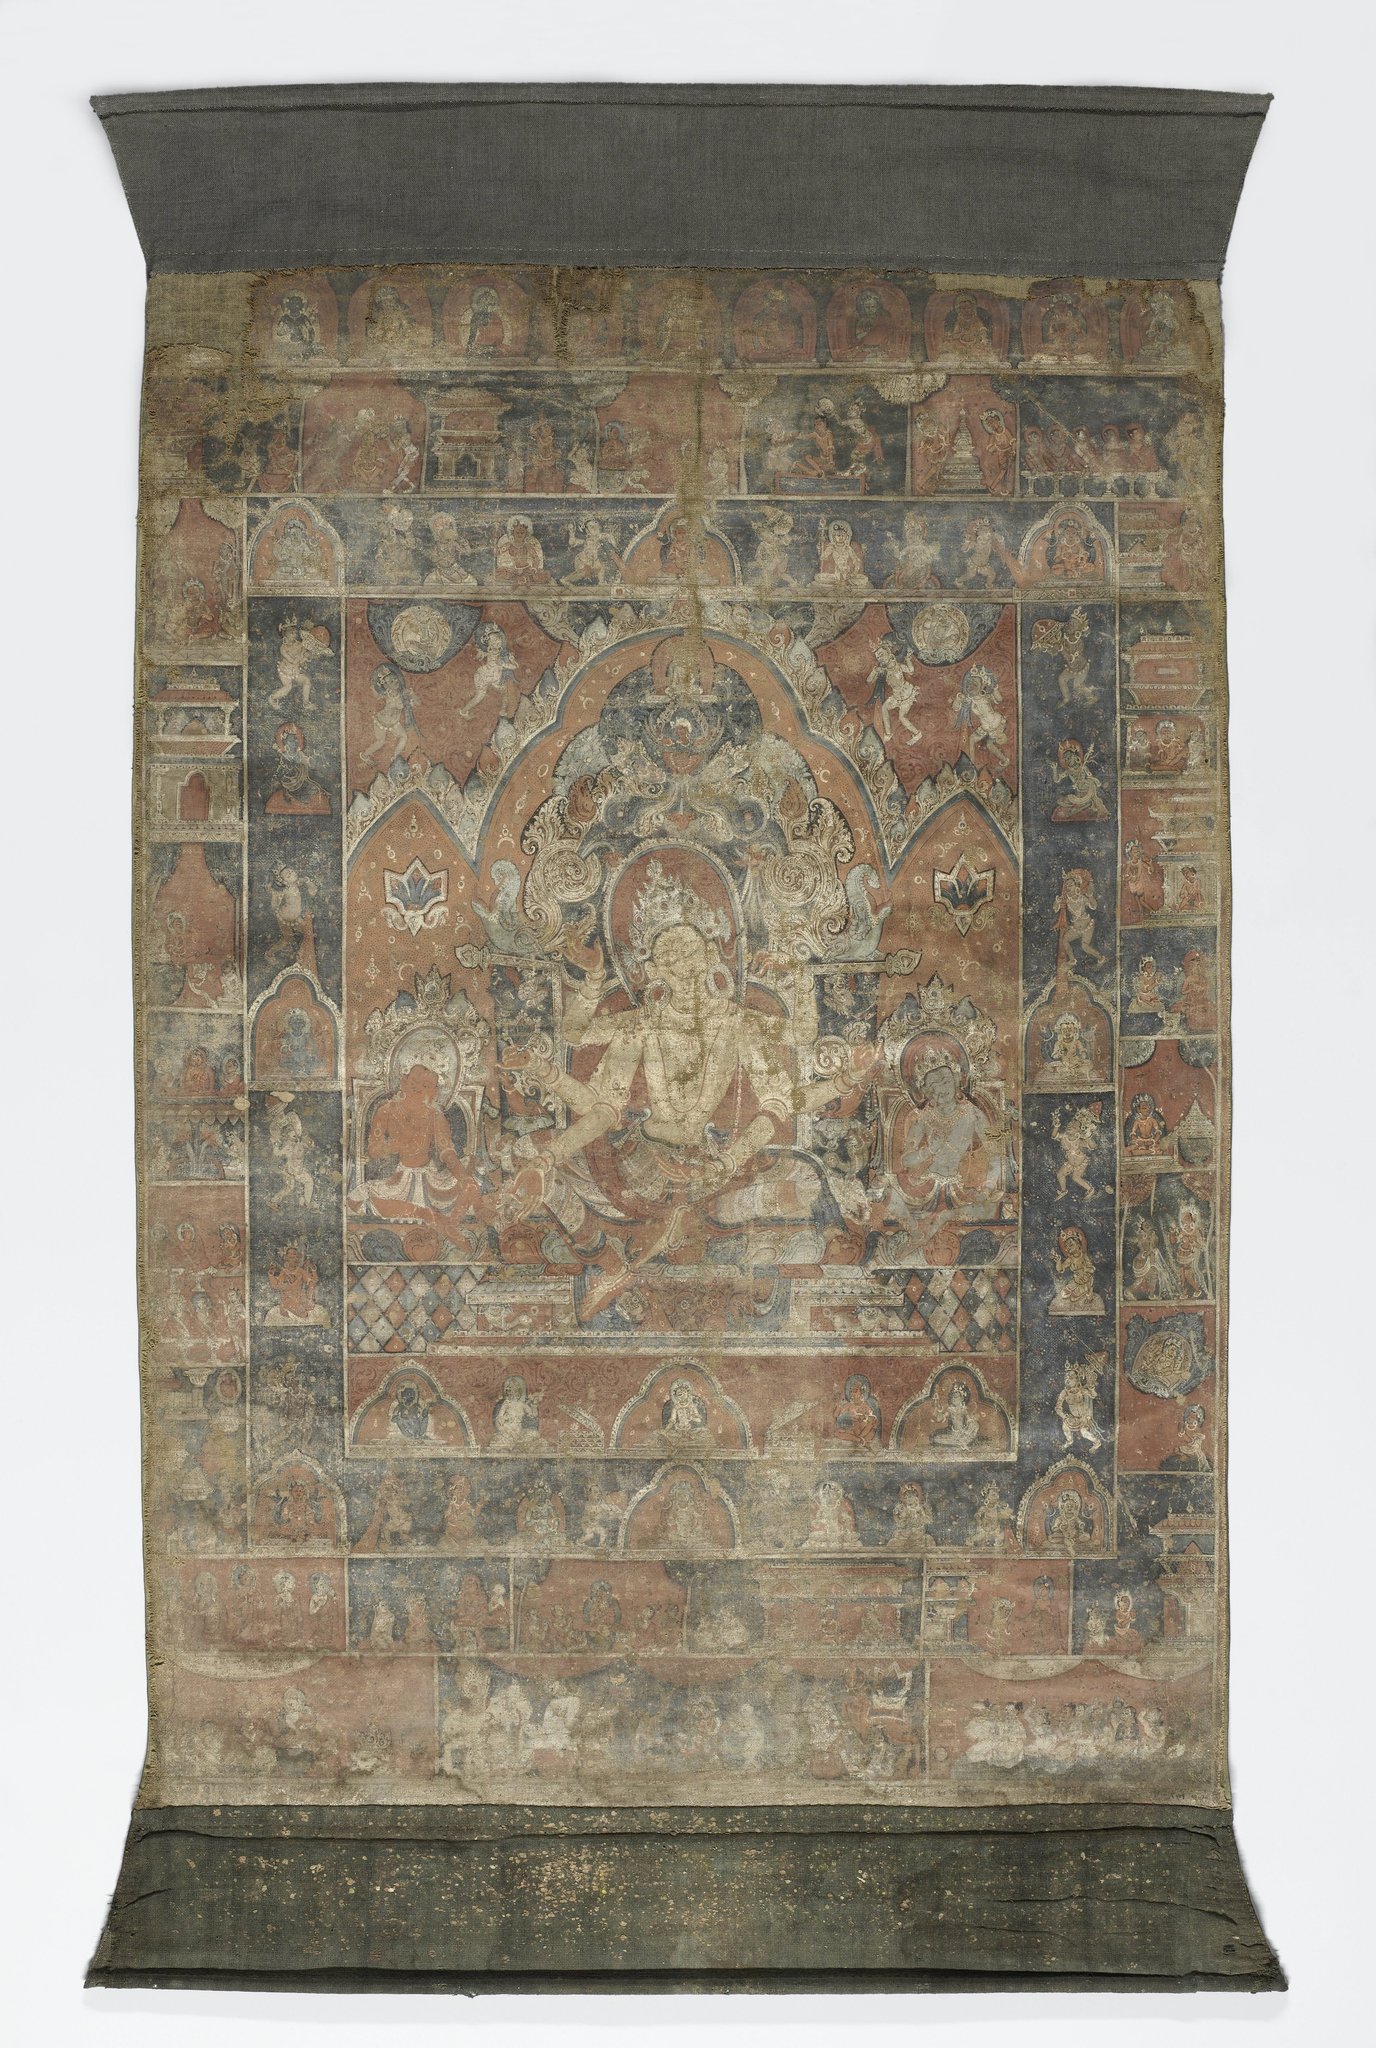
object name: tangka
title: Schildering op doek van Vasudhara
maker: Anonymous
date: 1500-1600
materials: canvas, dye, paint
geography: nepal